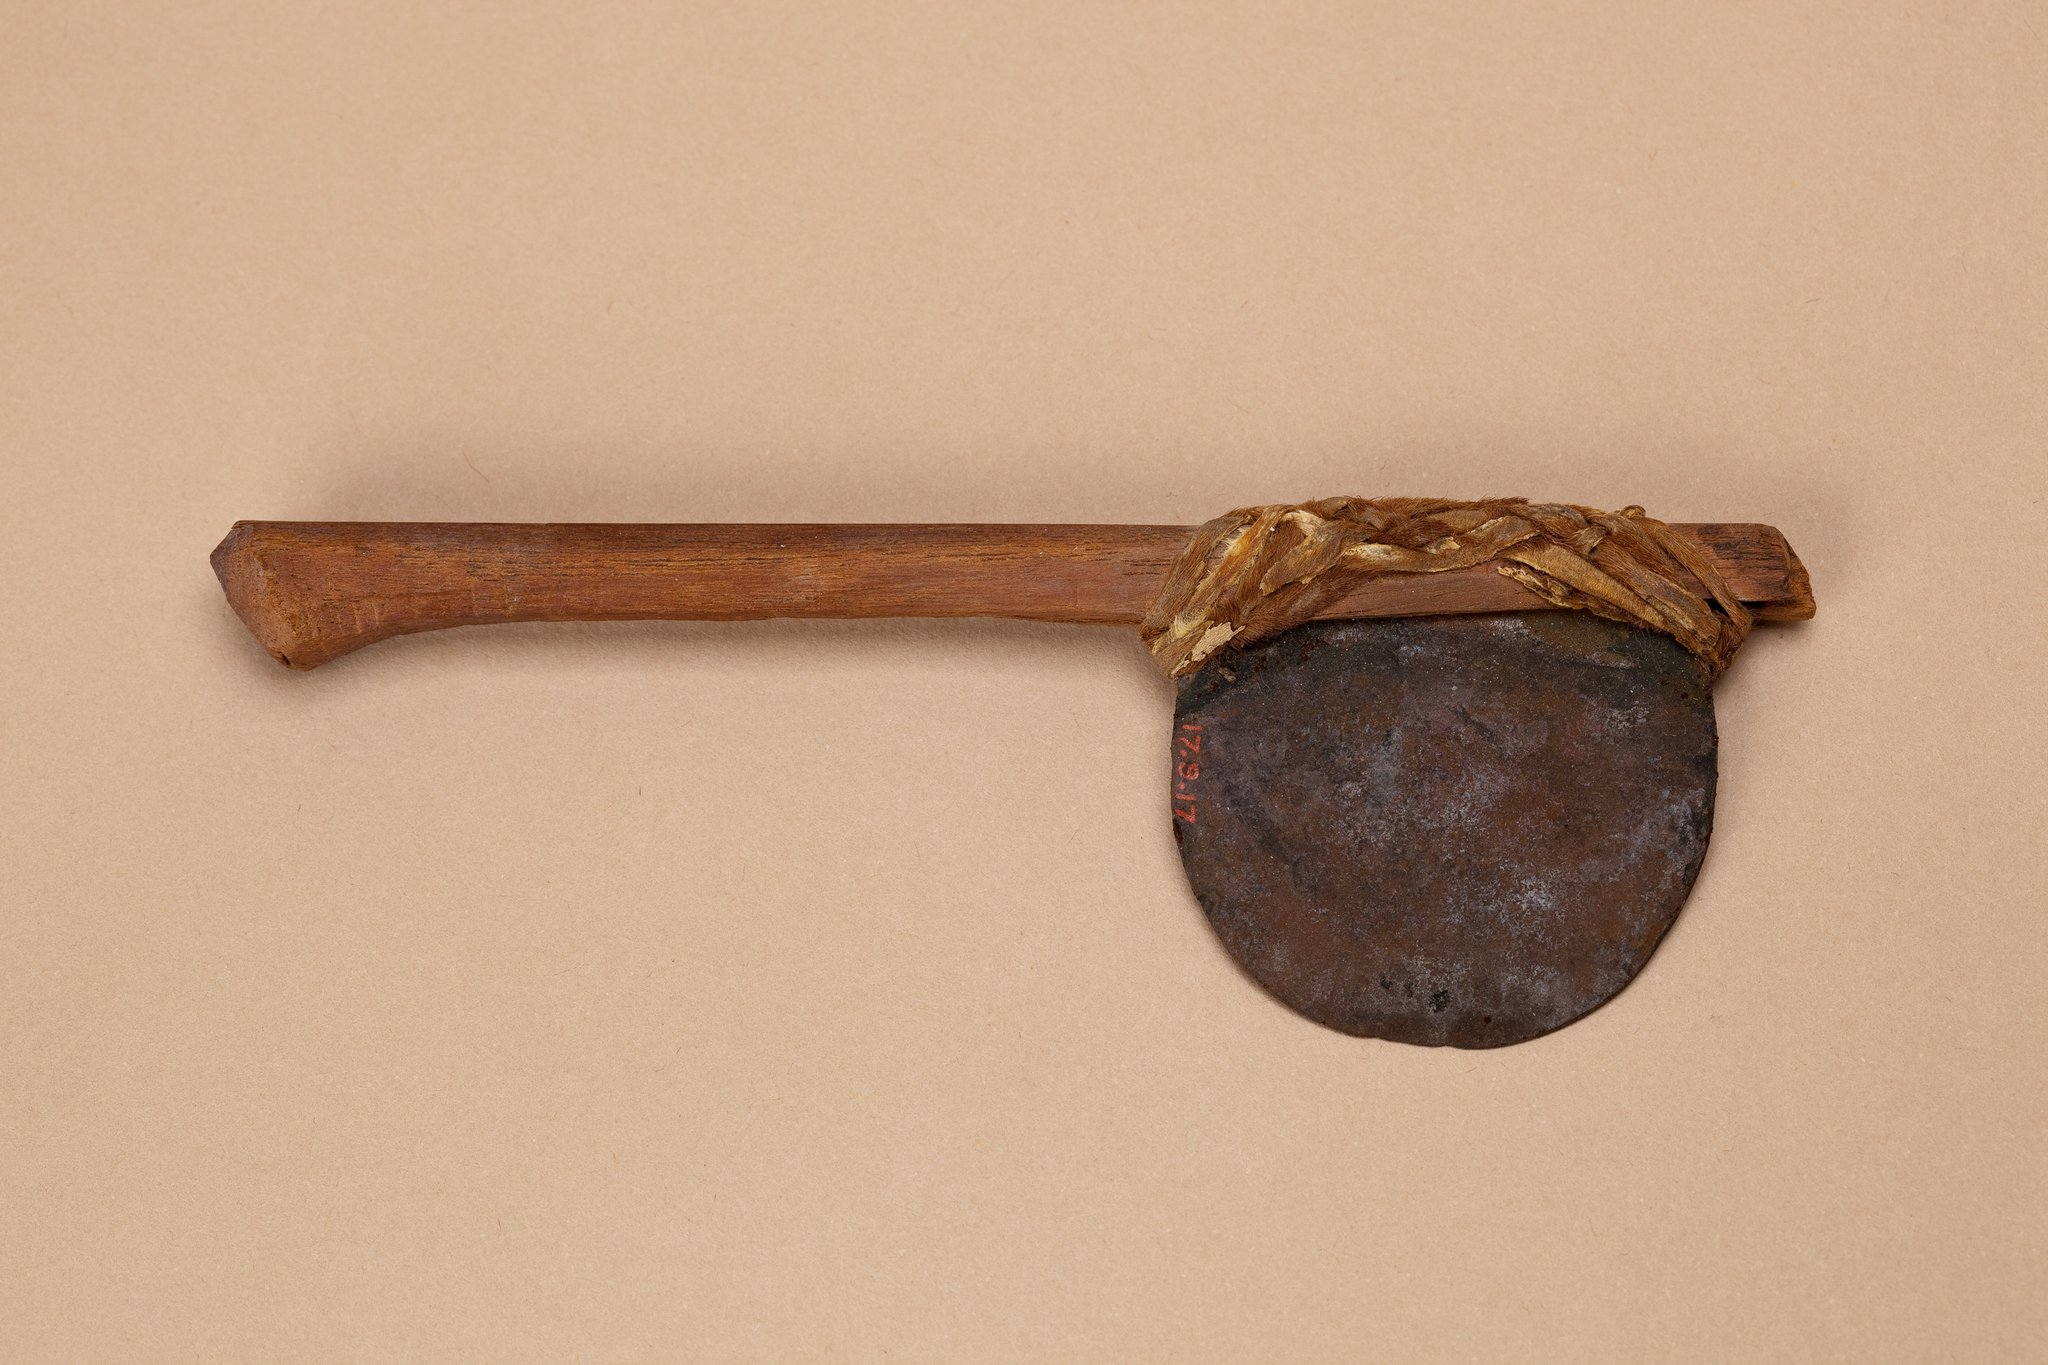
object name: model ax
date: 1981-1802 BCE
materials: copper, wood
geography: egypt